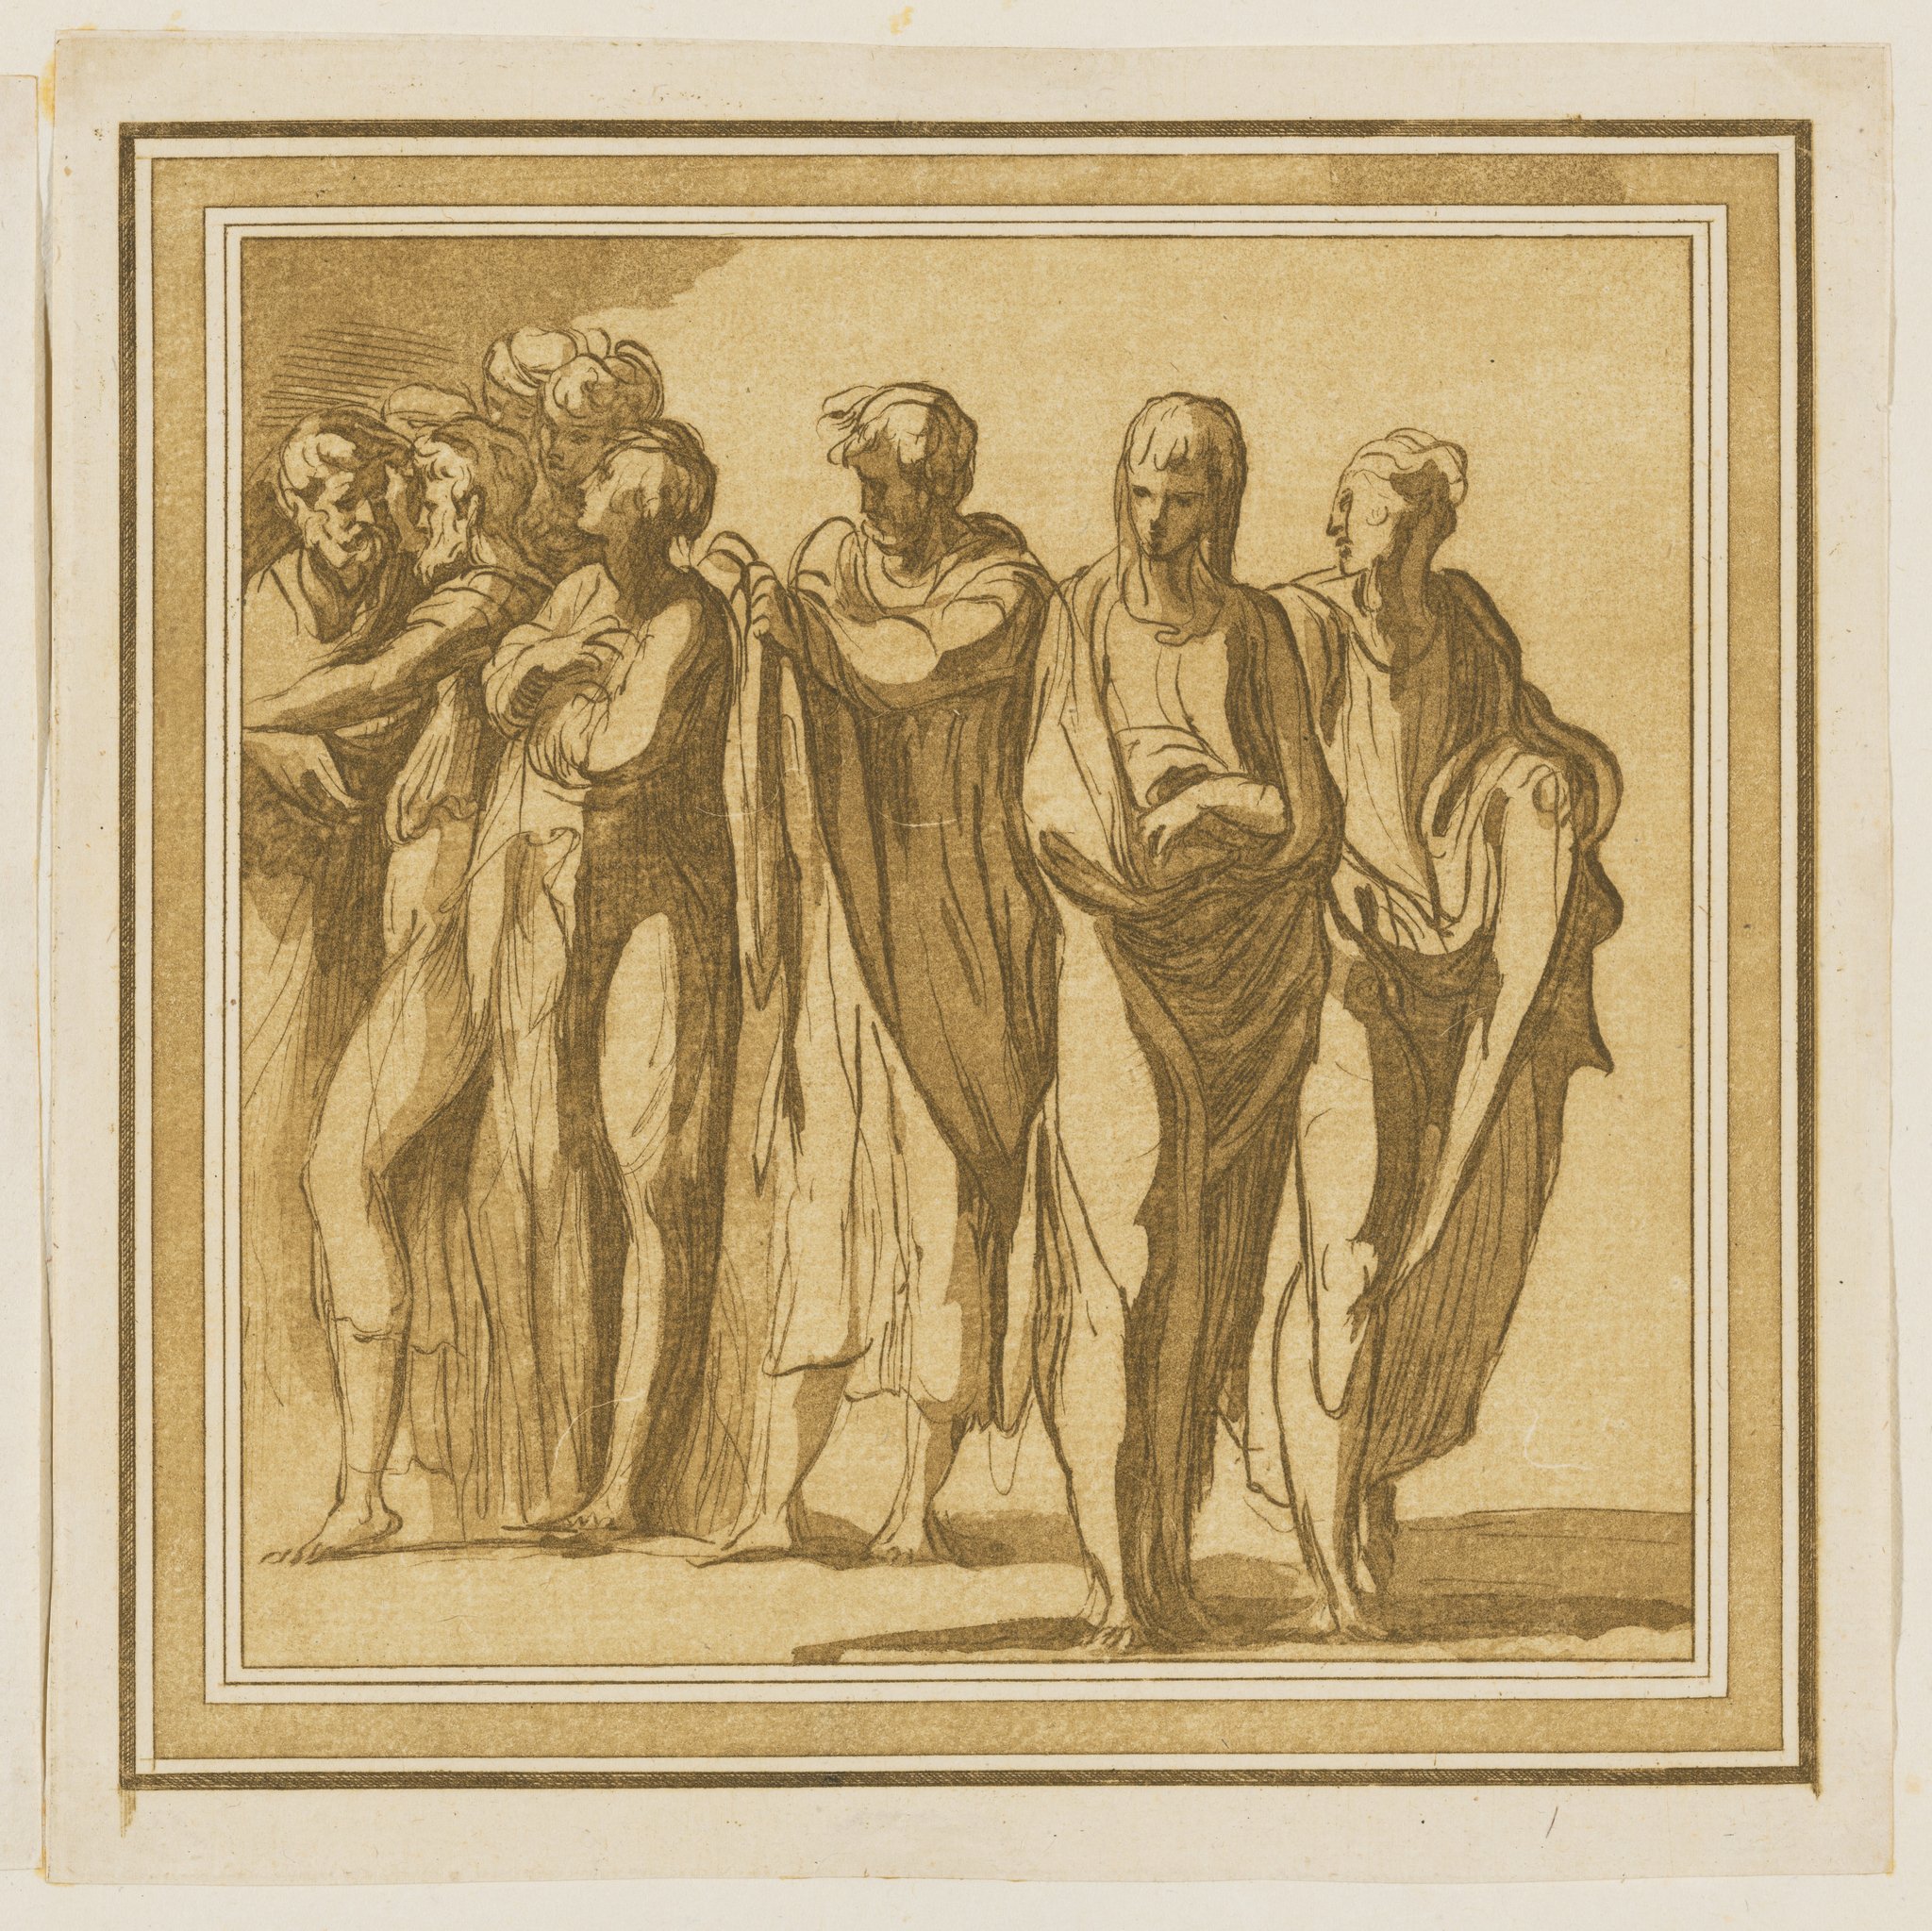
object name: print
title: Six Apostles Looking Backwards, from Prove di Vari Rami Inediti [...]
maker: francesco rosaspina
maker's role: artist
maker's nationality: italian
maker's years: 1762-1841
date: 1801-1900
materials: ink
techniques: aquatint, etching